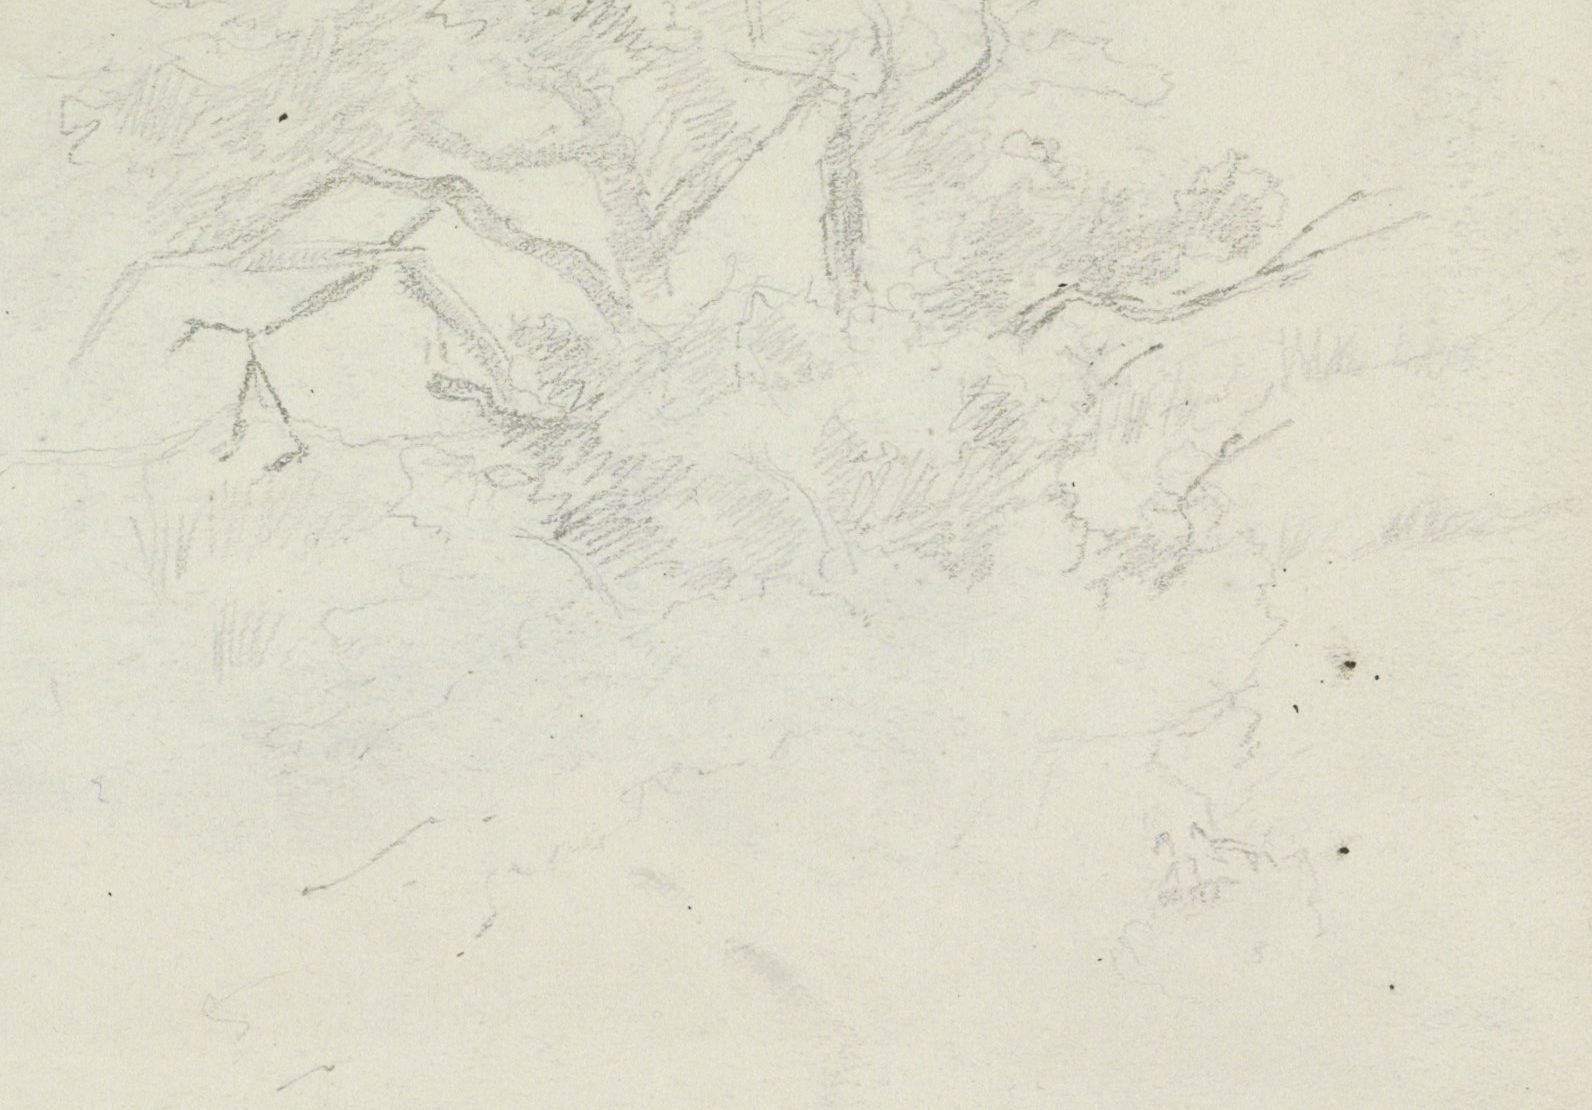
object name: sketchbook leaf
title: Bomen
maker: jozef israëls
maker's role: draughtsman, painter, print maker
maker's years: 1824-1911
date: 1885-1902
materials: paper, pencil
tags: trees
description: Blad 17 recto uit een schetsboek met 17 bladen.